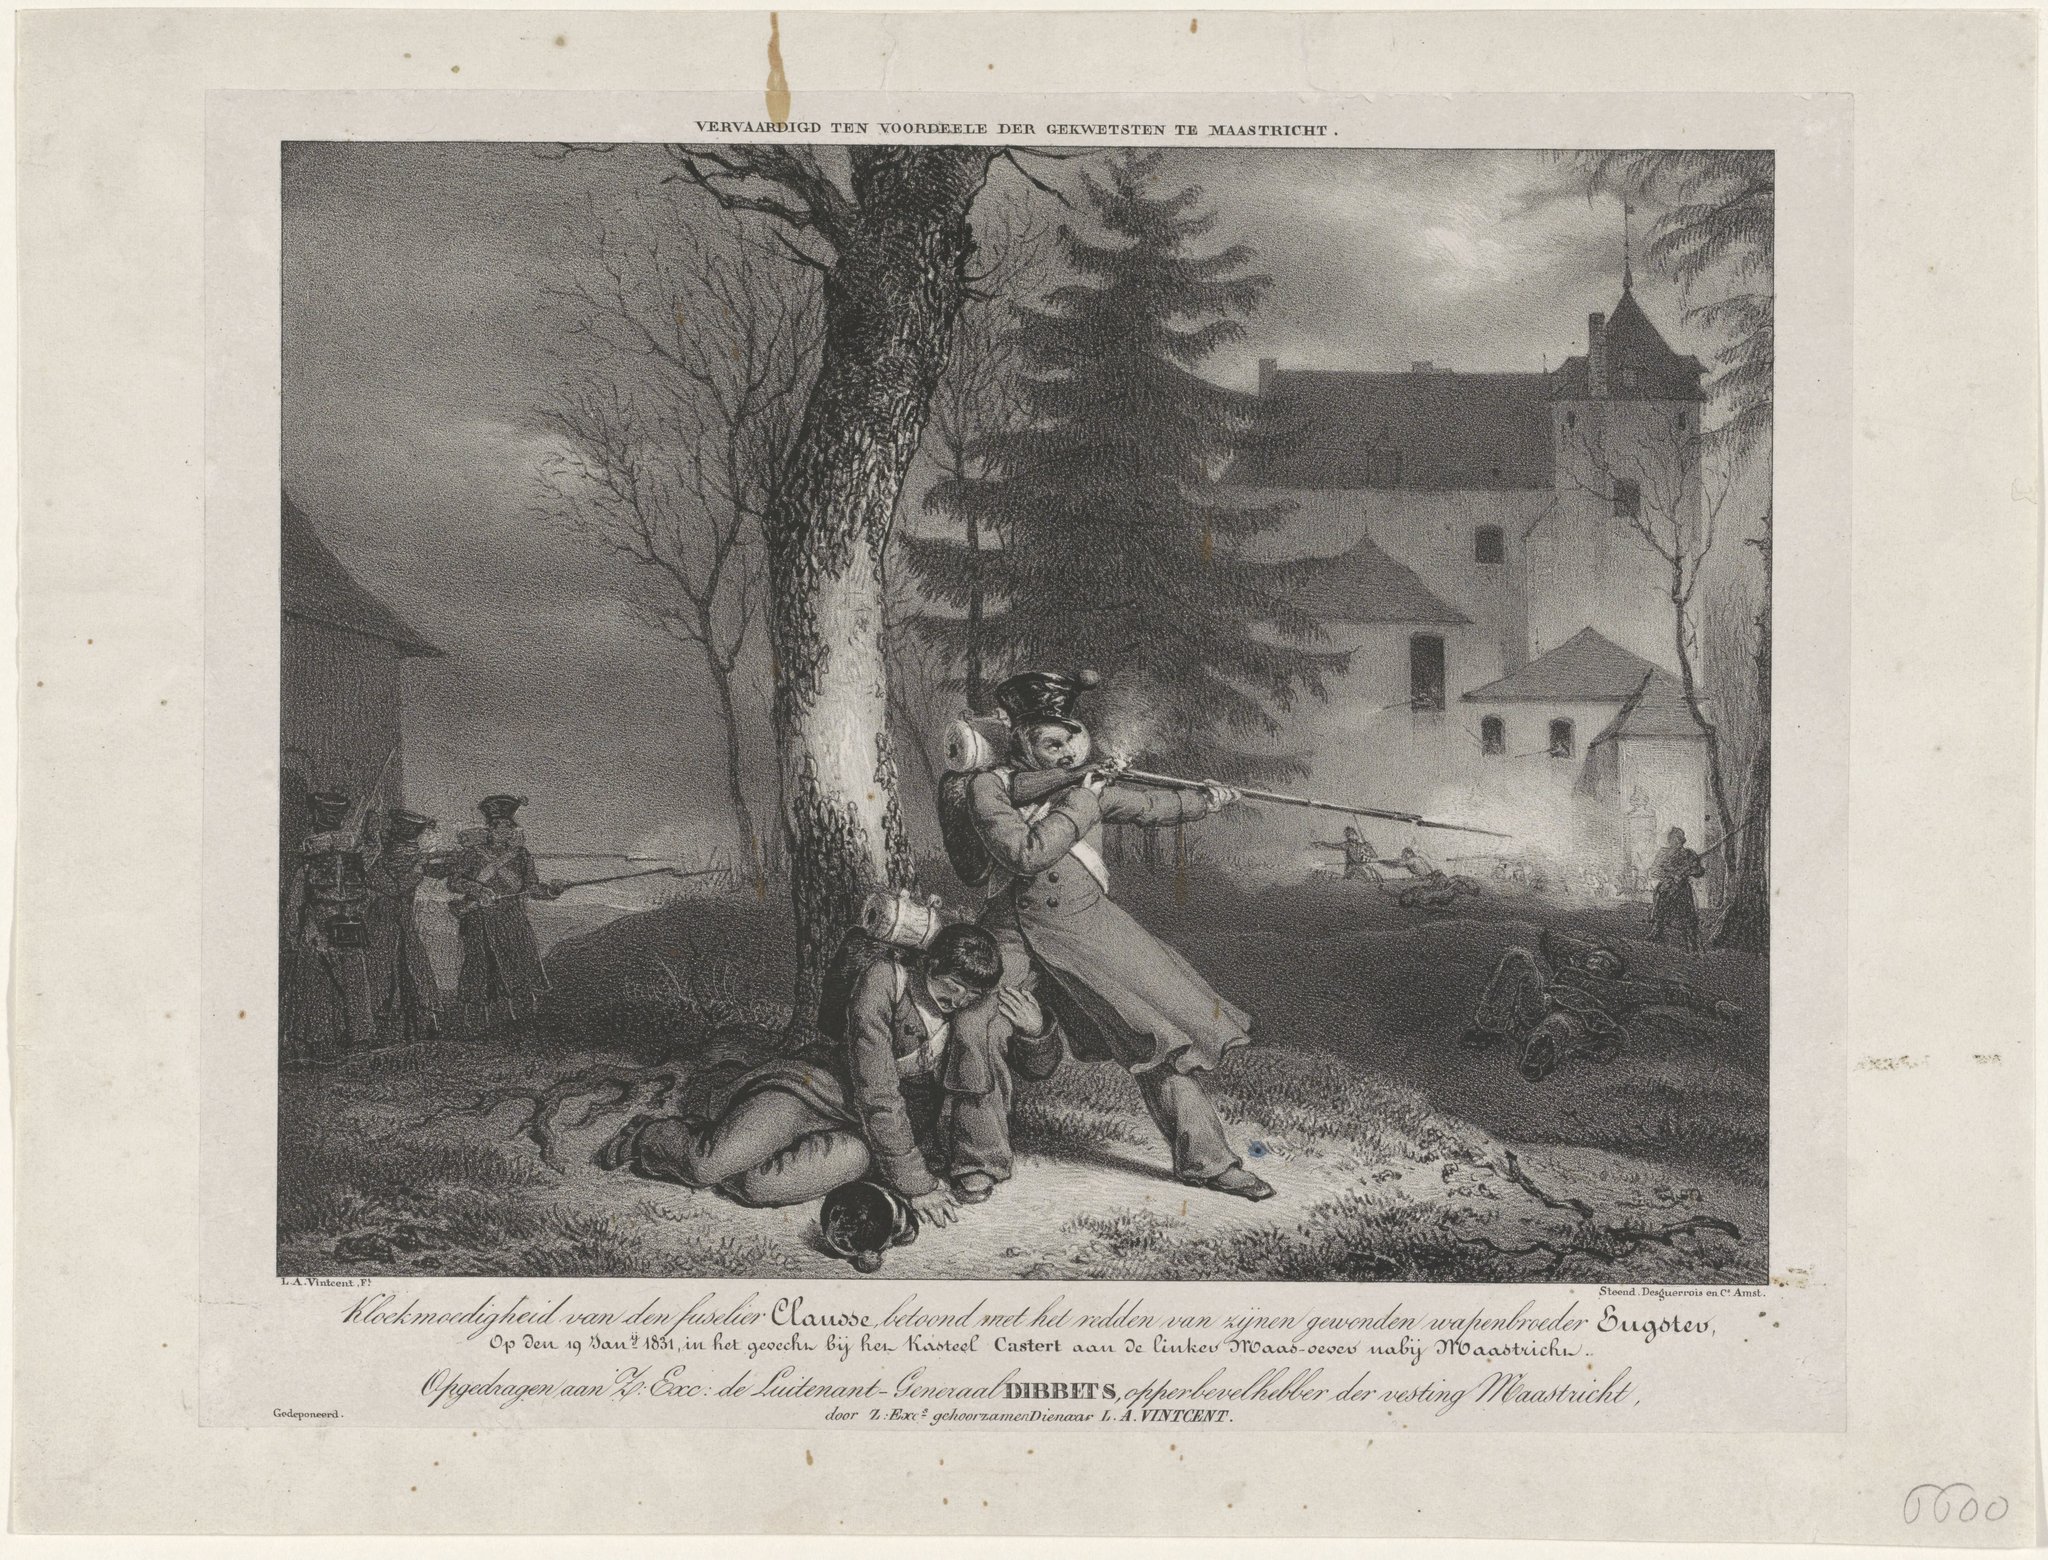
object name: print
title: Kloekmoedigheid van den fuselier Clausse, betoond met het redden van zijnen gewonden wapenbroeder Engster, Op den 19 Jan.ij 1831, in het gevecht bij het Kasteel Castert aan de linker Maas-oever nabij Maastricht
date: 1831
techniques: printmaking, lithograph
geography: amsterdam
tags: small groups in single combat in place of battle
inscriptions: collector's mark: Lugt 2228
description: De Nederlandse fuselier Clausse verdedigt zich bij een boom tegen de naderende Belgische troepen, aan zijn voeten ligt de gewonde Engster, in de achtergrond het kasteel Caestert, 19 januari 1831.